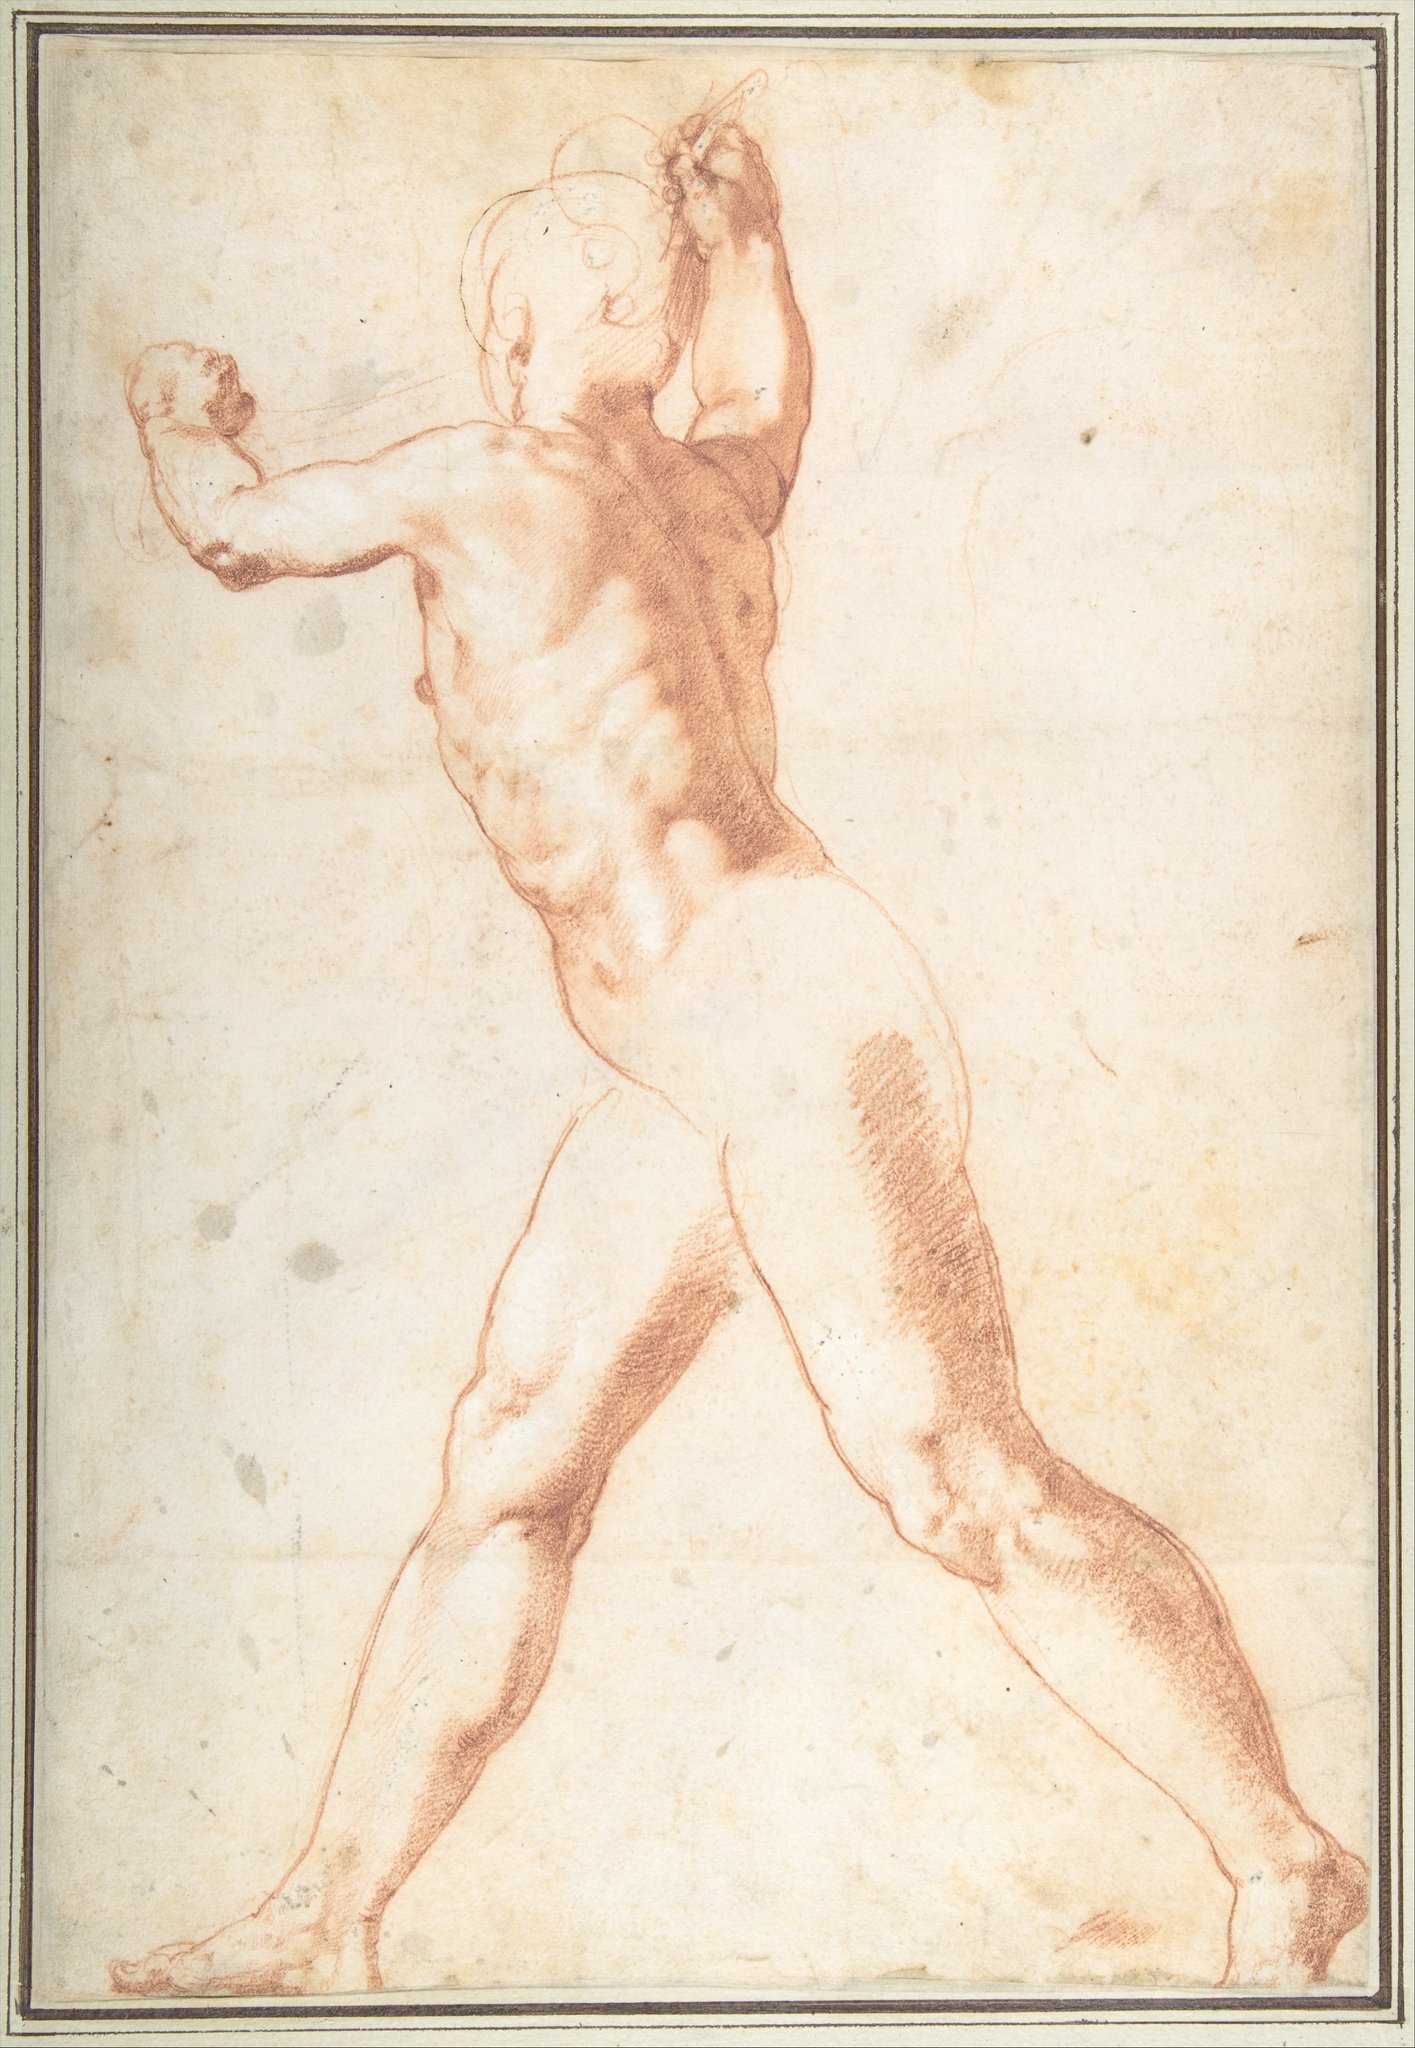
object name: drawing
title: Standing Nude Man (recto); Three Studies of Soldiers (verso)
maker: taddeo zuccaro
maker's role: artist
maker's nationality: italian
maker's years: 1529-1566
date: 1550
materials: chalk, gouache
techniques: highlighting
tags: male nudes